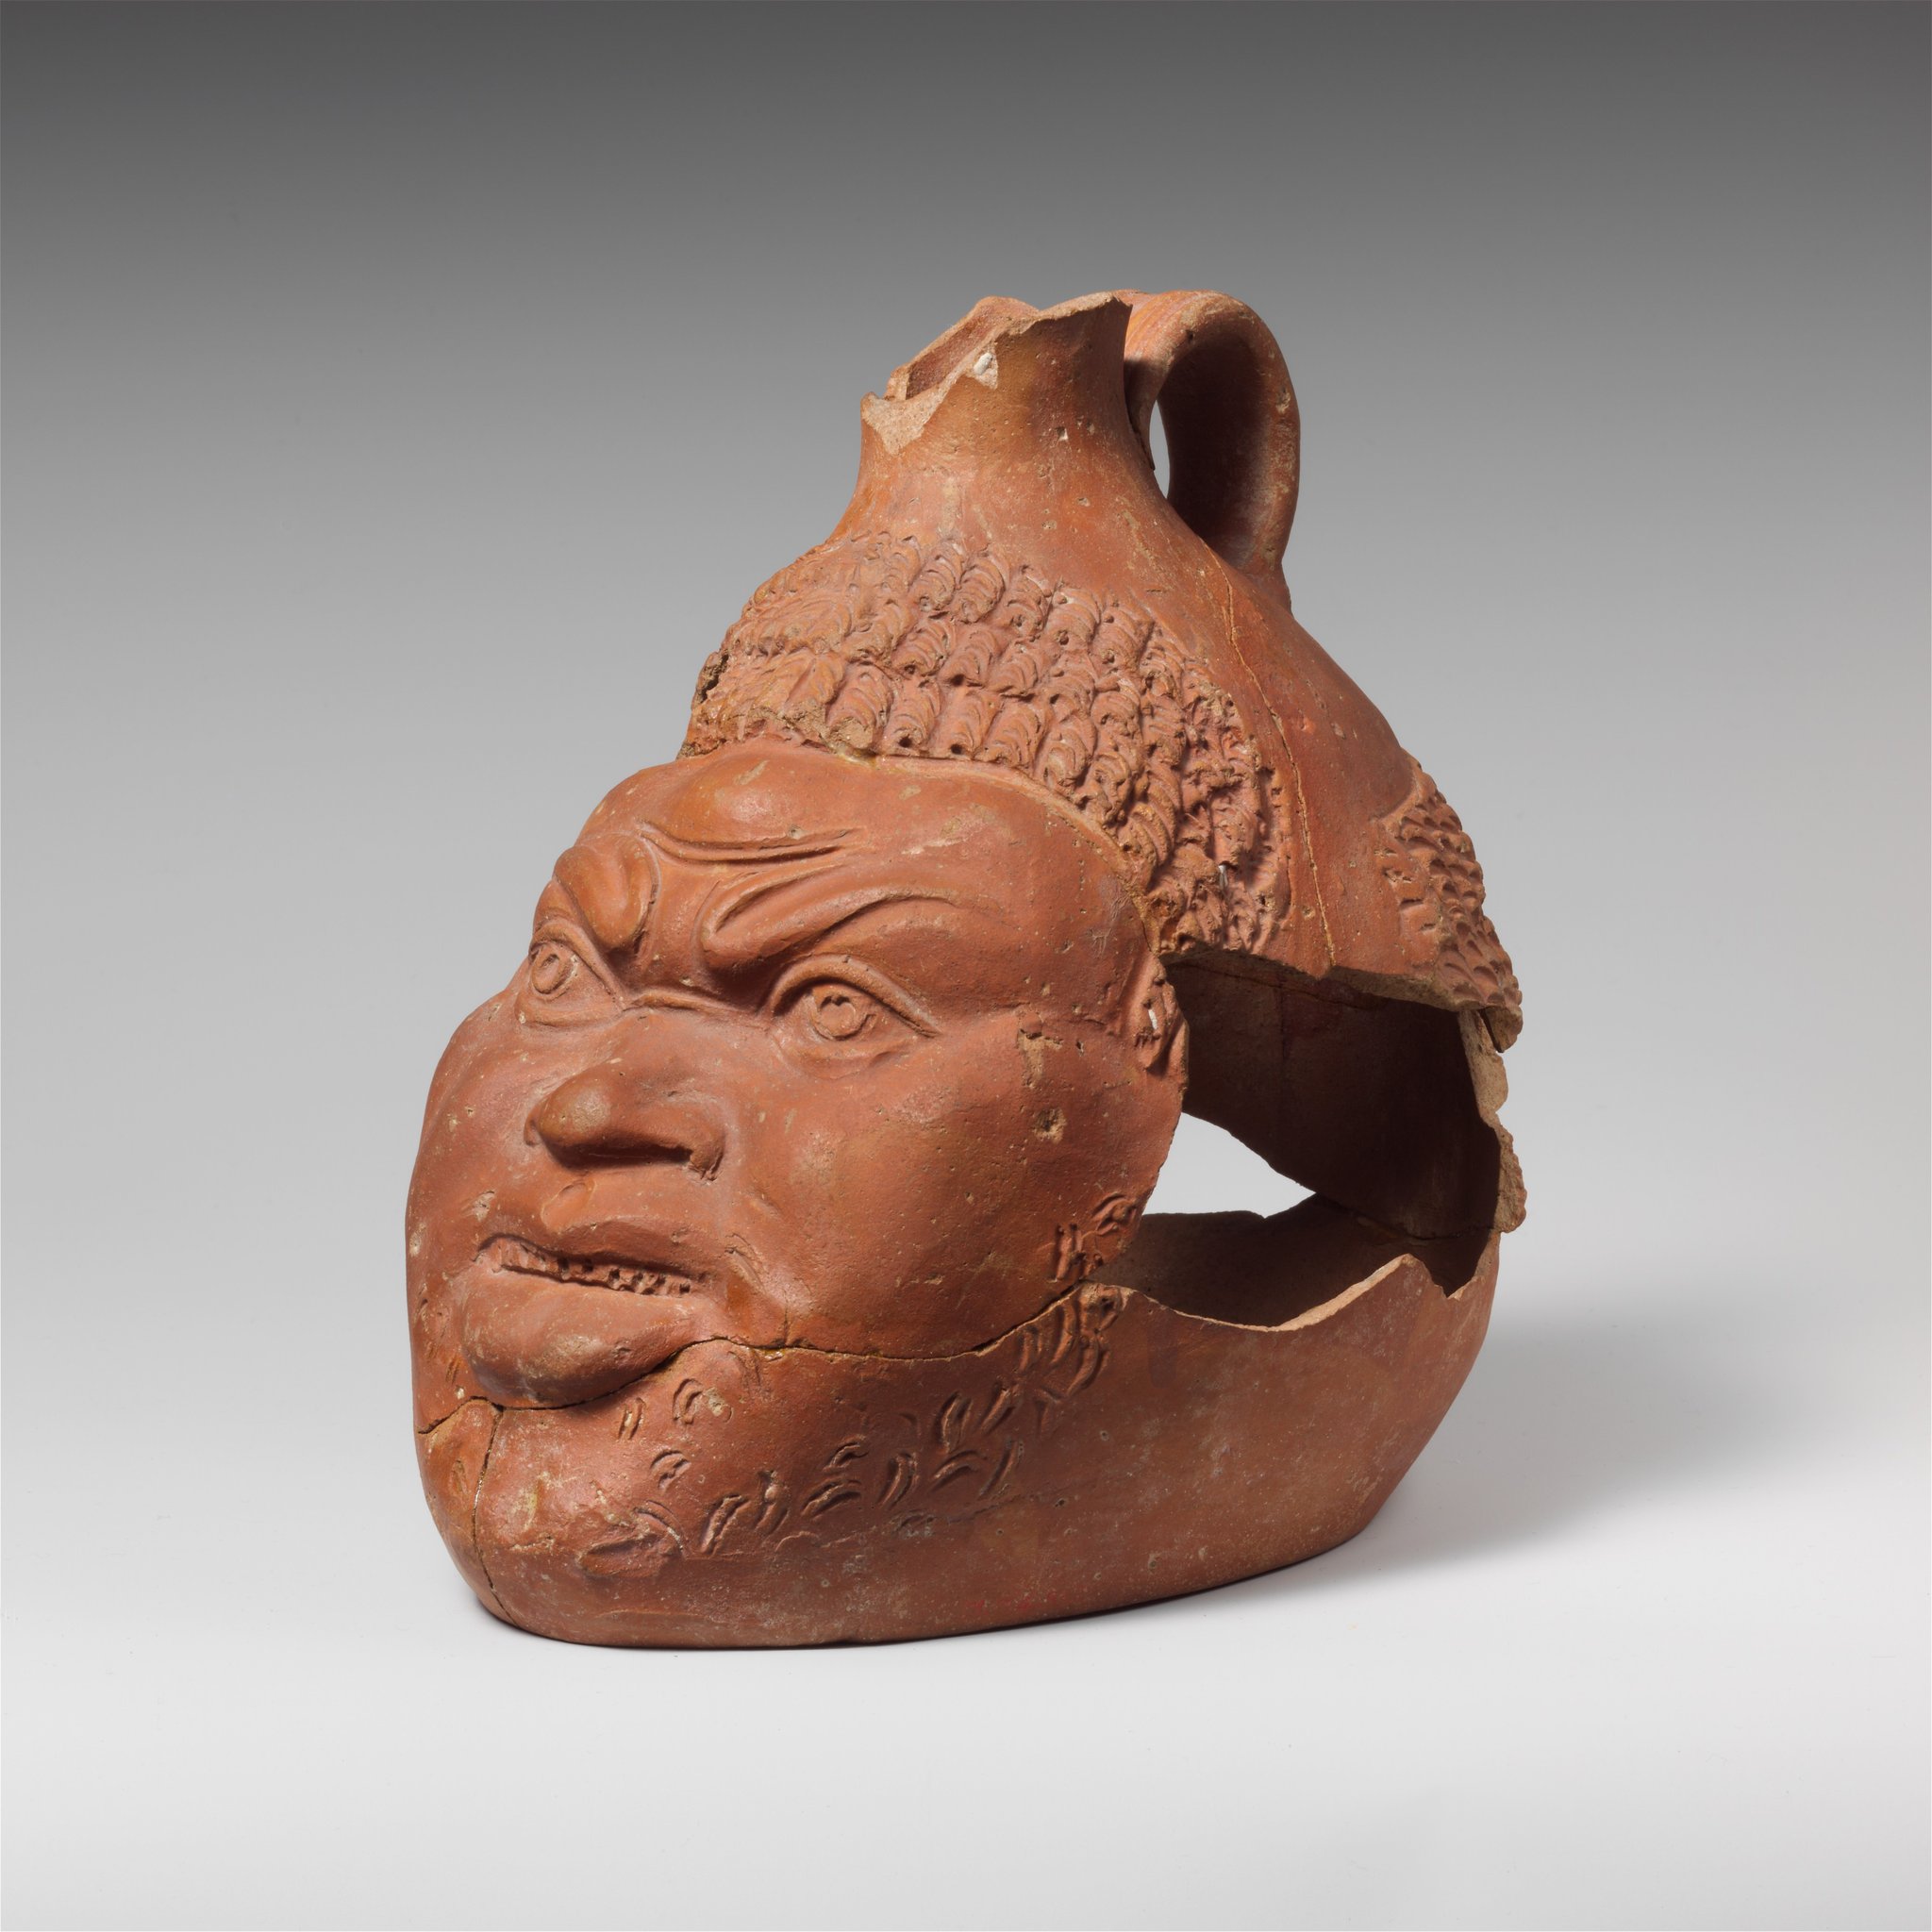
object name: jug in the shape of a head of an african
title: Terracotta jug in the shape of a head of a Black African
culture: roman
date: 201-300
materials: terracotta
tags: heads